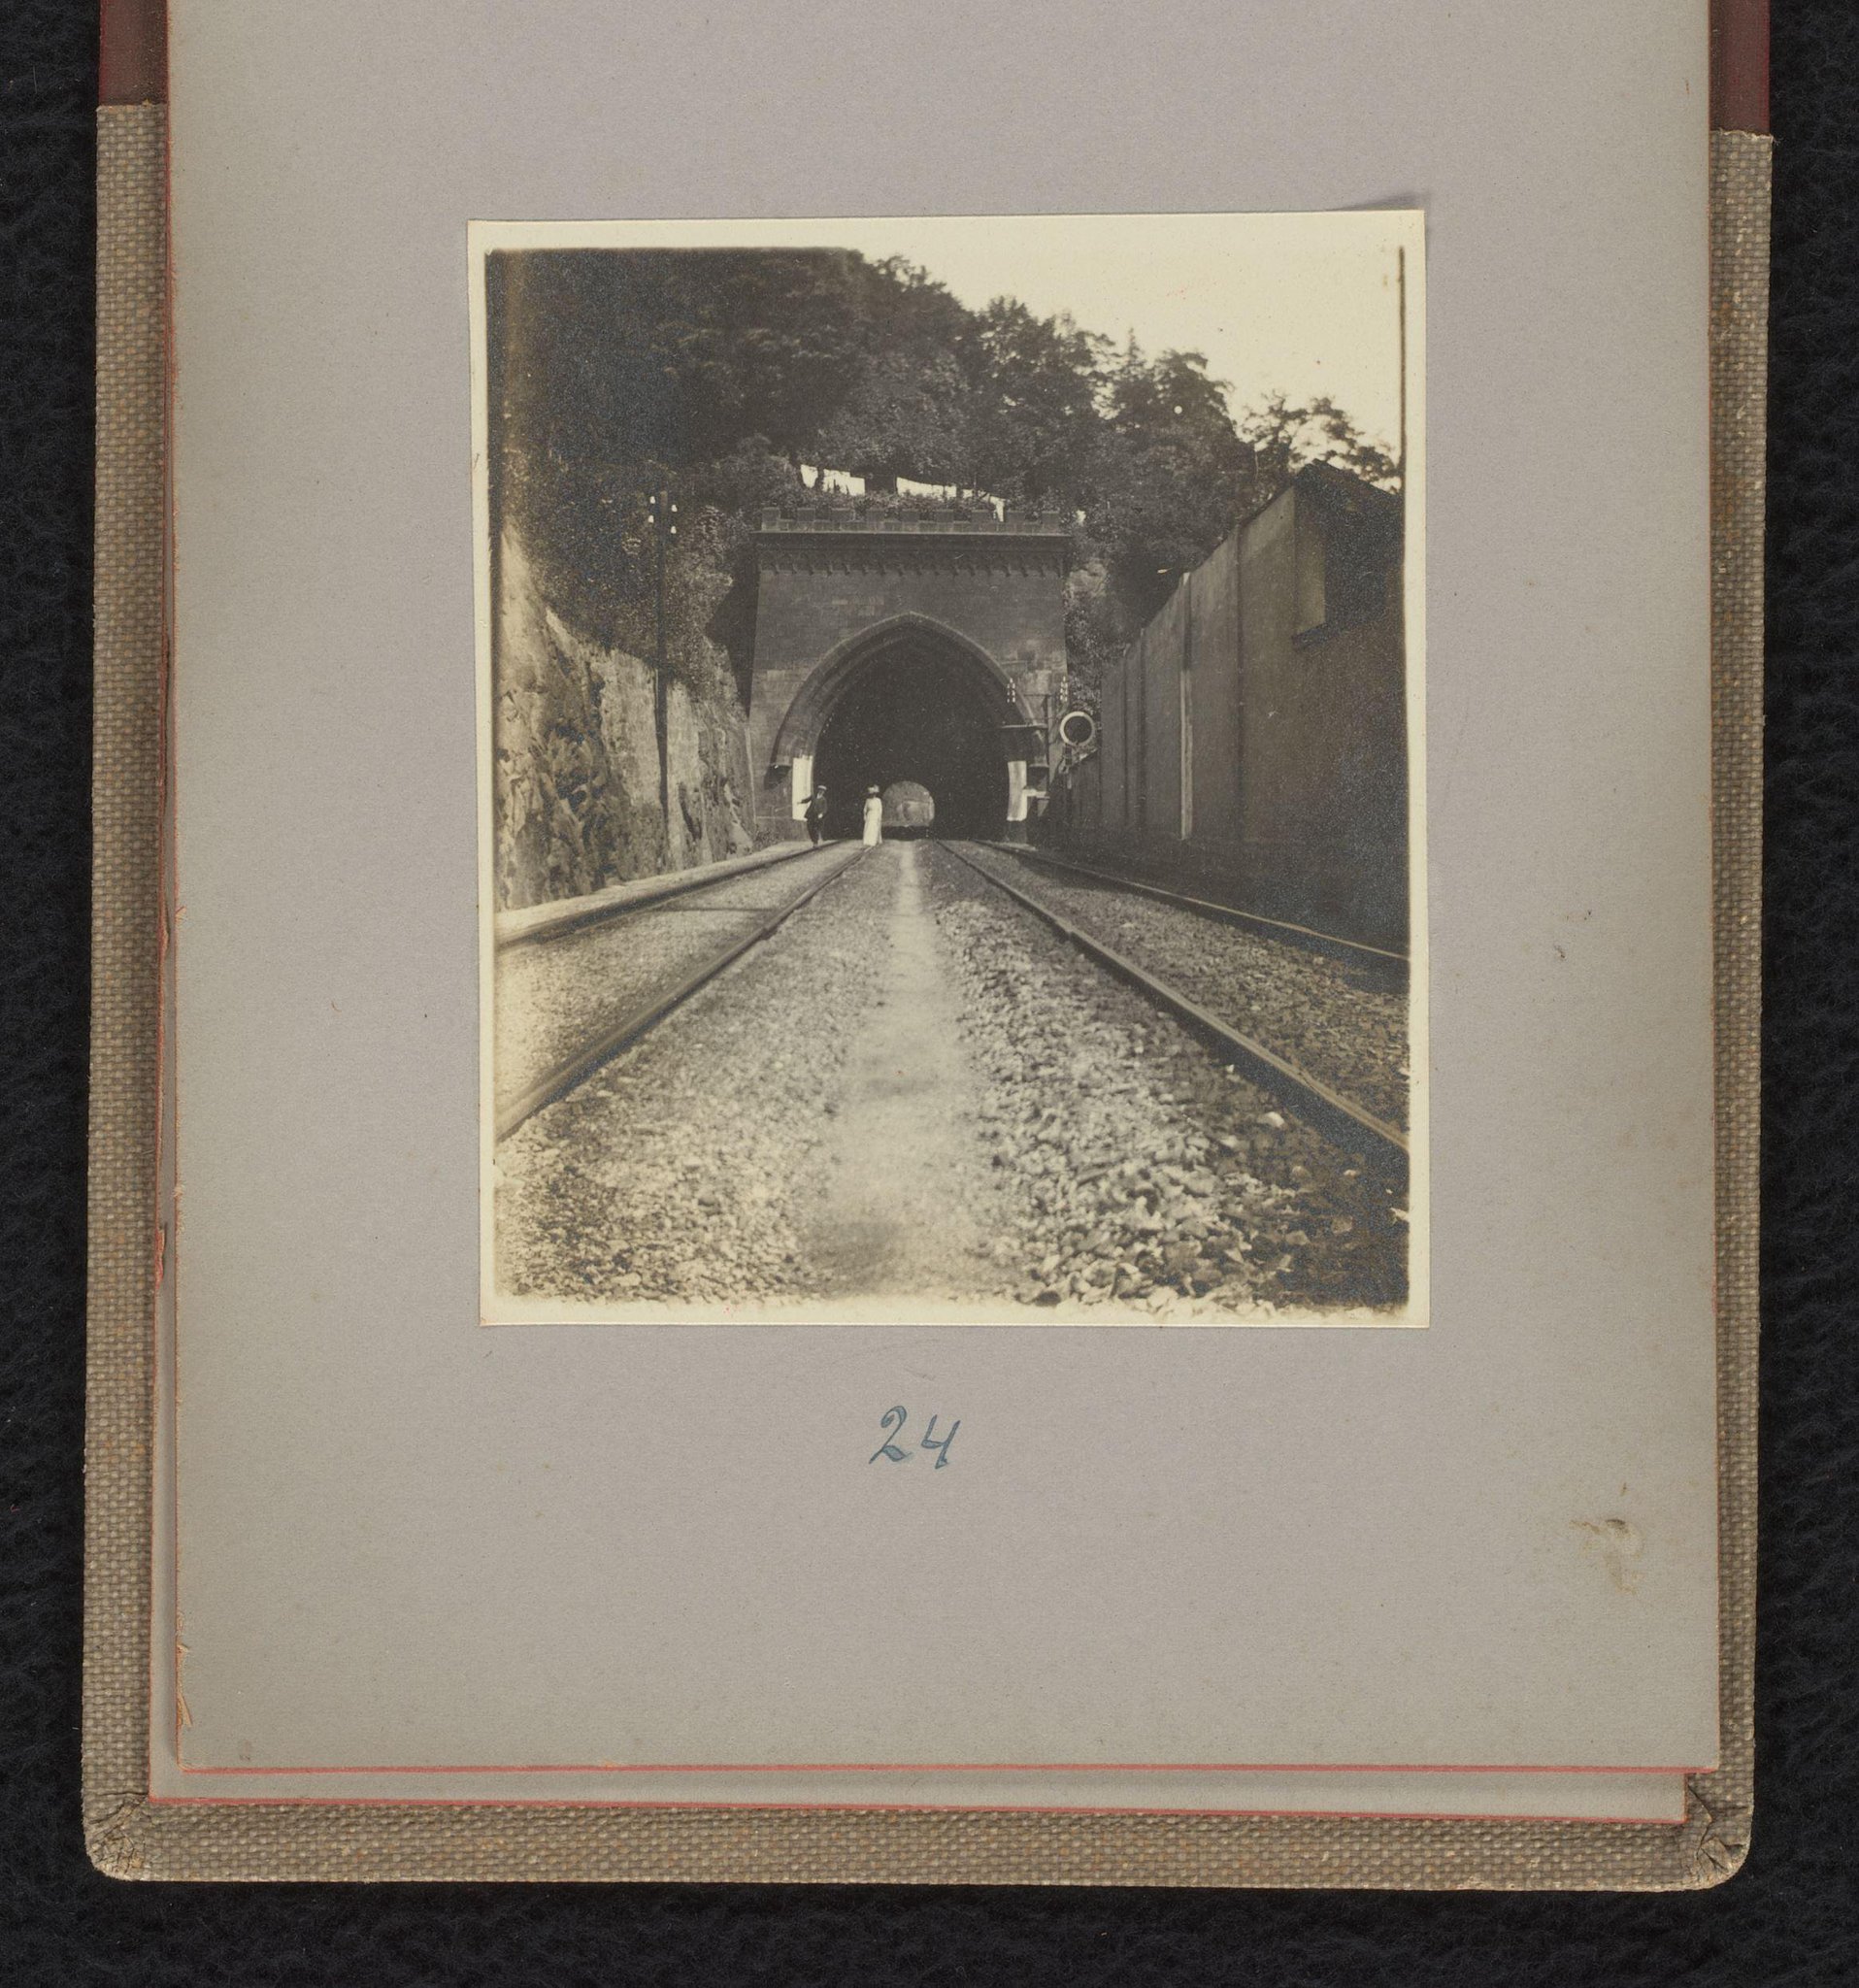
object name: photograph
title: De spoorlijn Weenen-Dresden bij Tetschen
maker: hermann johannes kessler (boelie)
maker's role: voetballer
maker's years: 1896-1971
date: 1910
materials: paper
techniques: gelatin silver print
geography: decín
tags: johan herman kessler (jan), railway, train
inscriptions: number: ‘24’